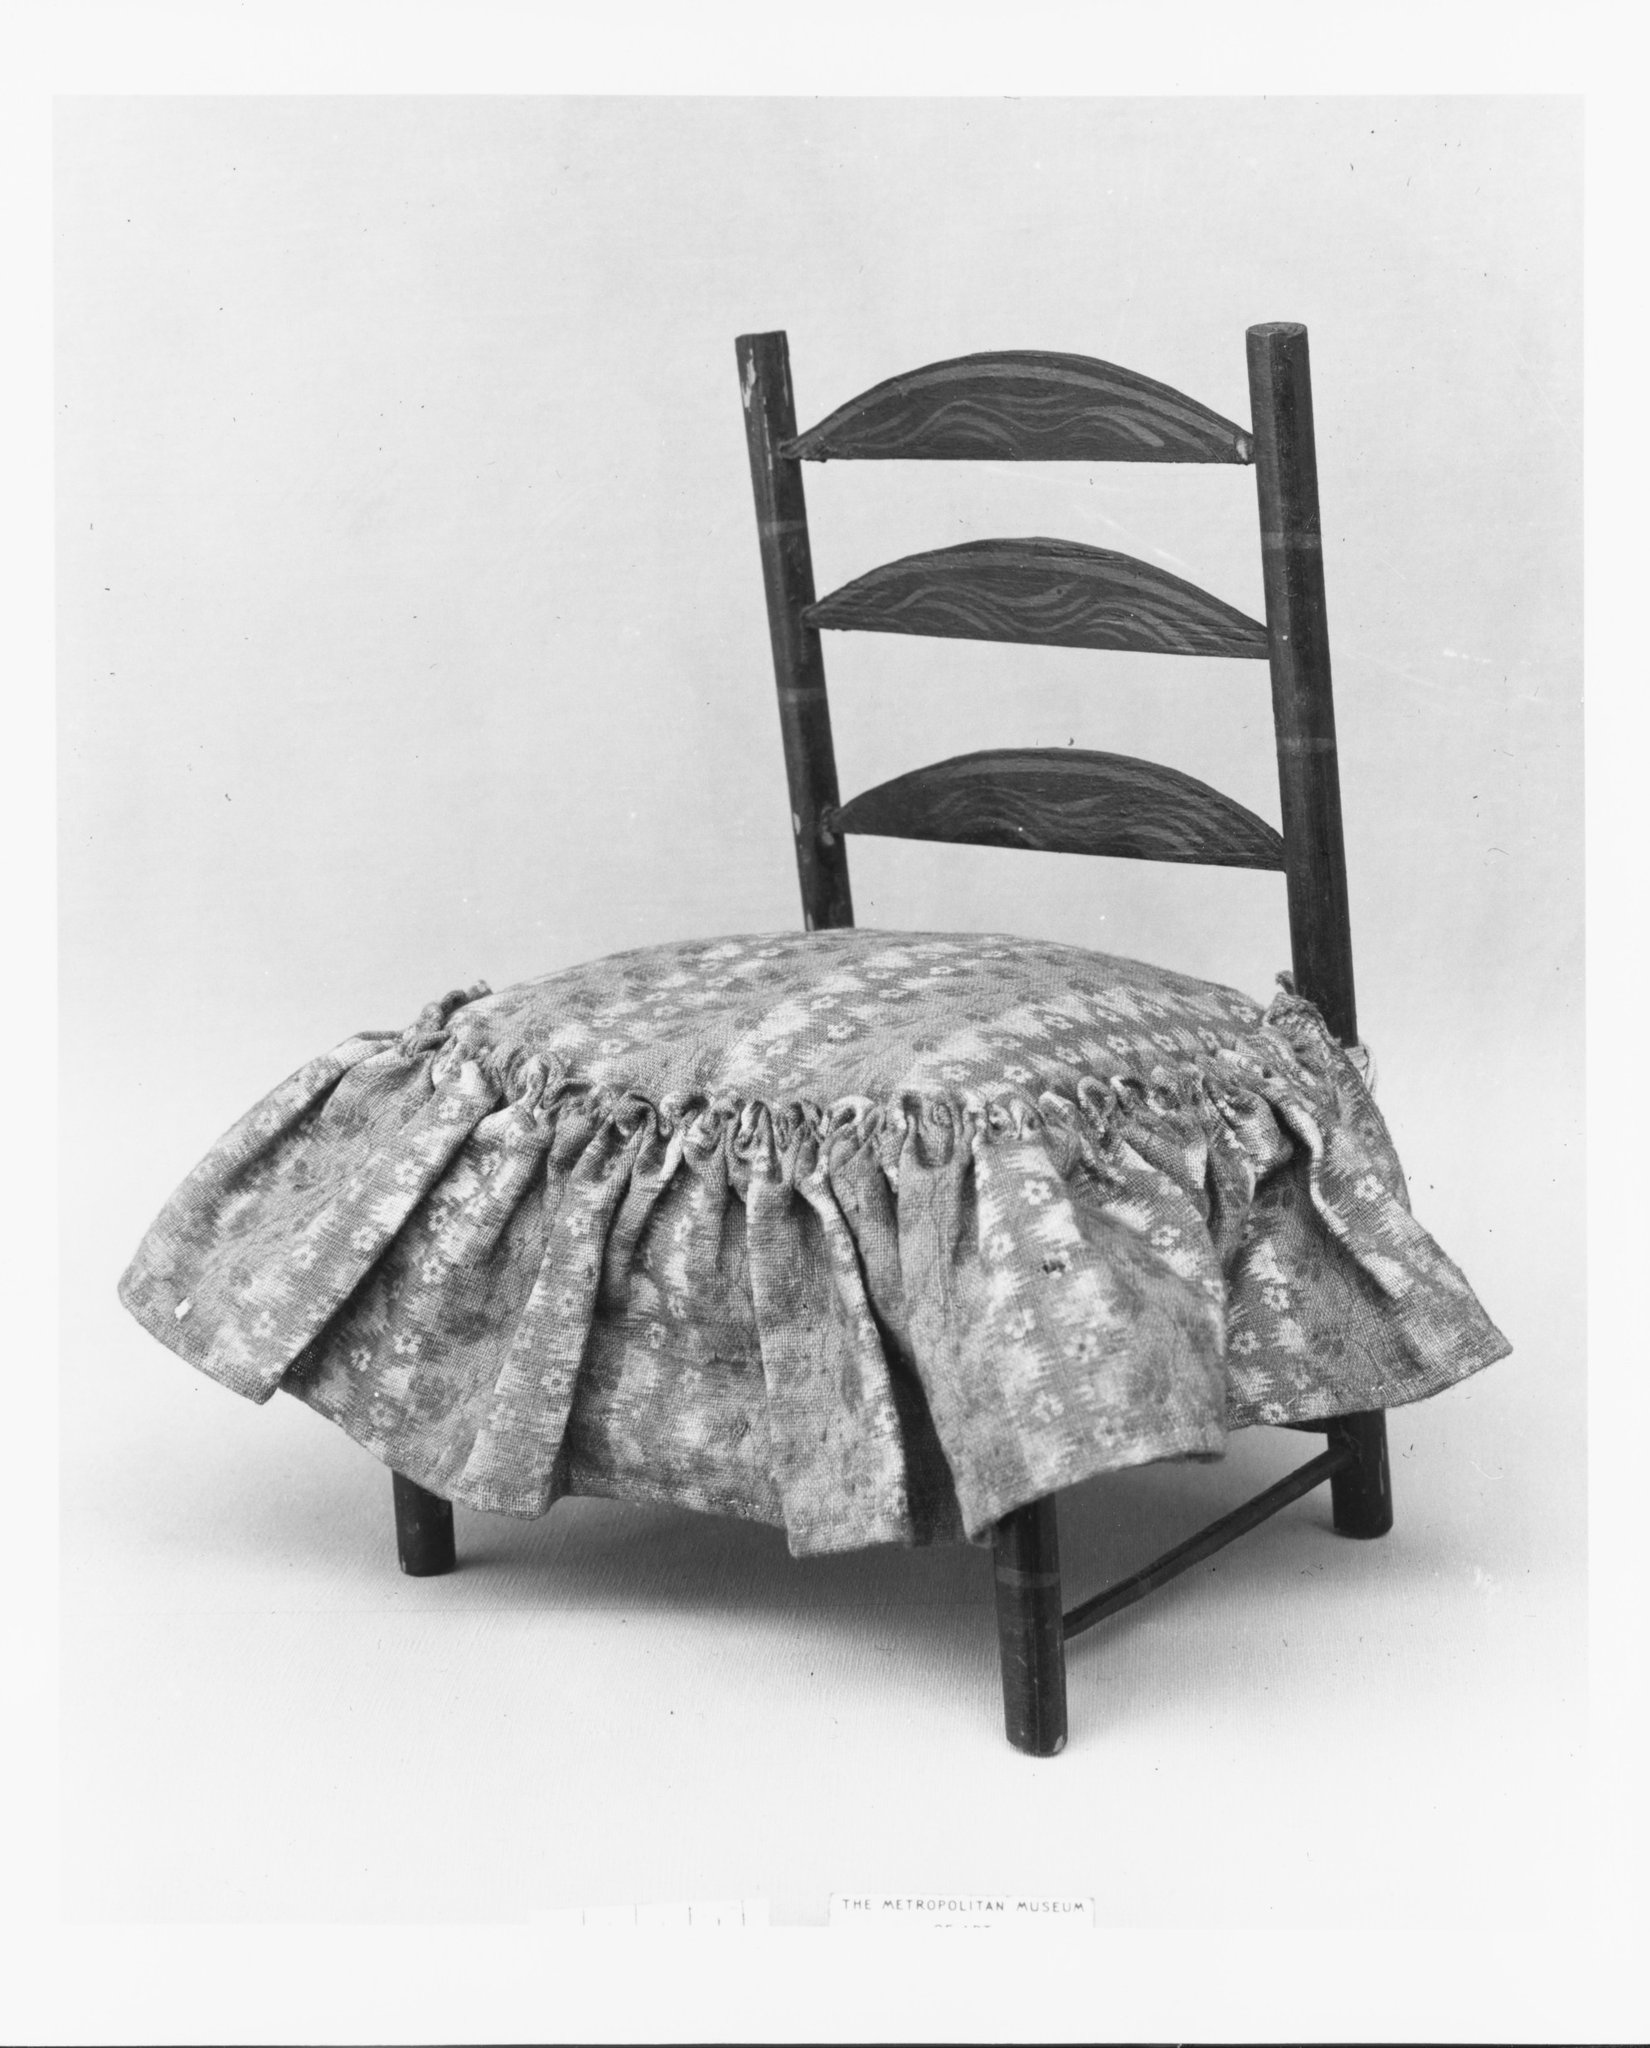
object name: chair model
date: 1770-1800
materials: wood